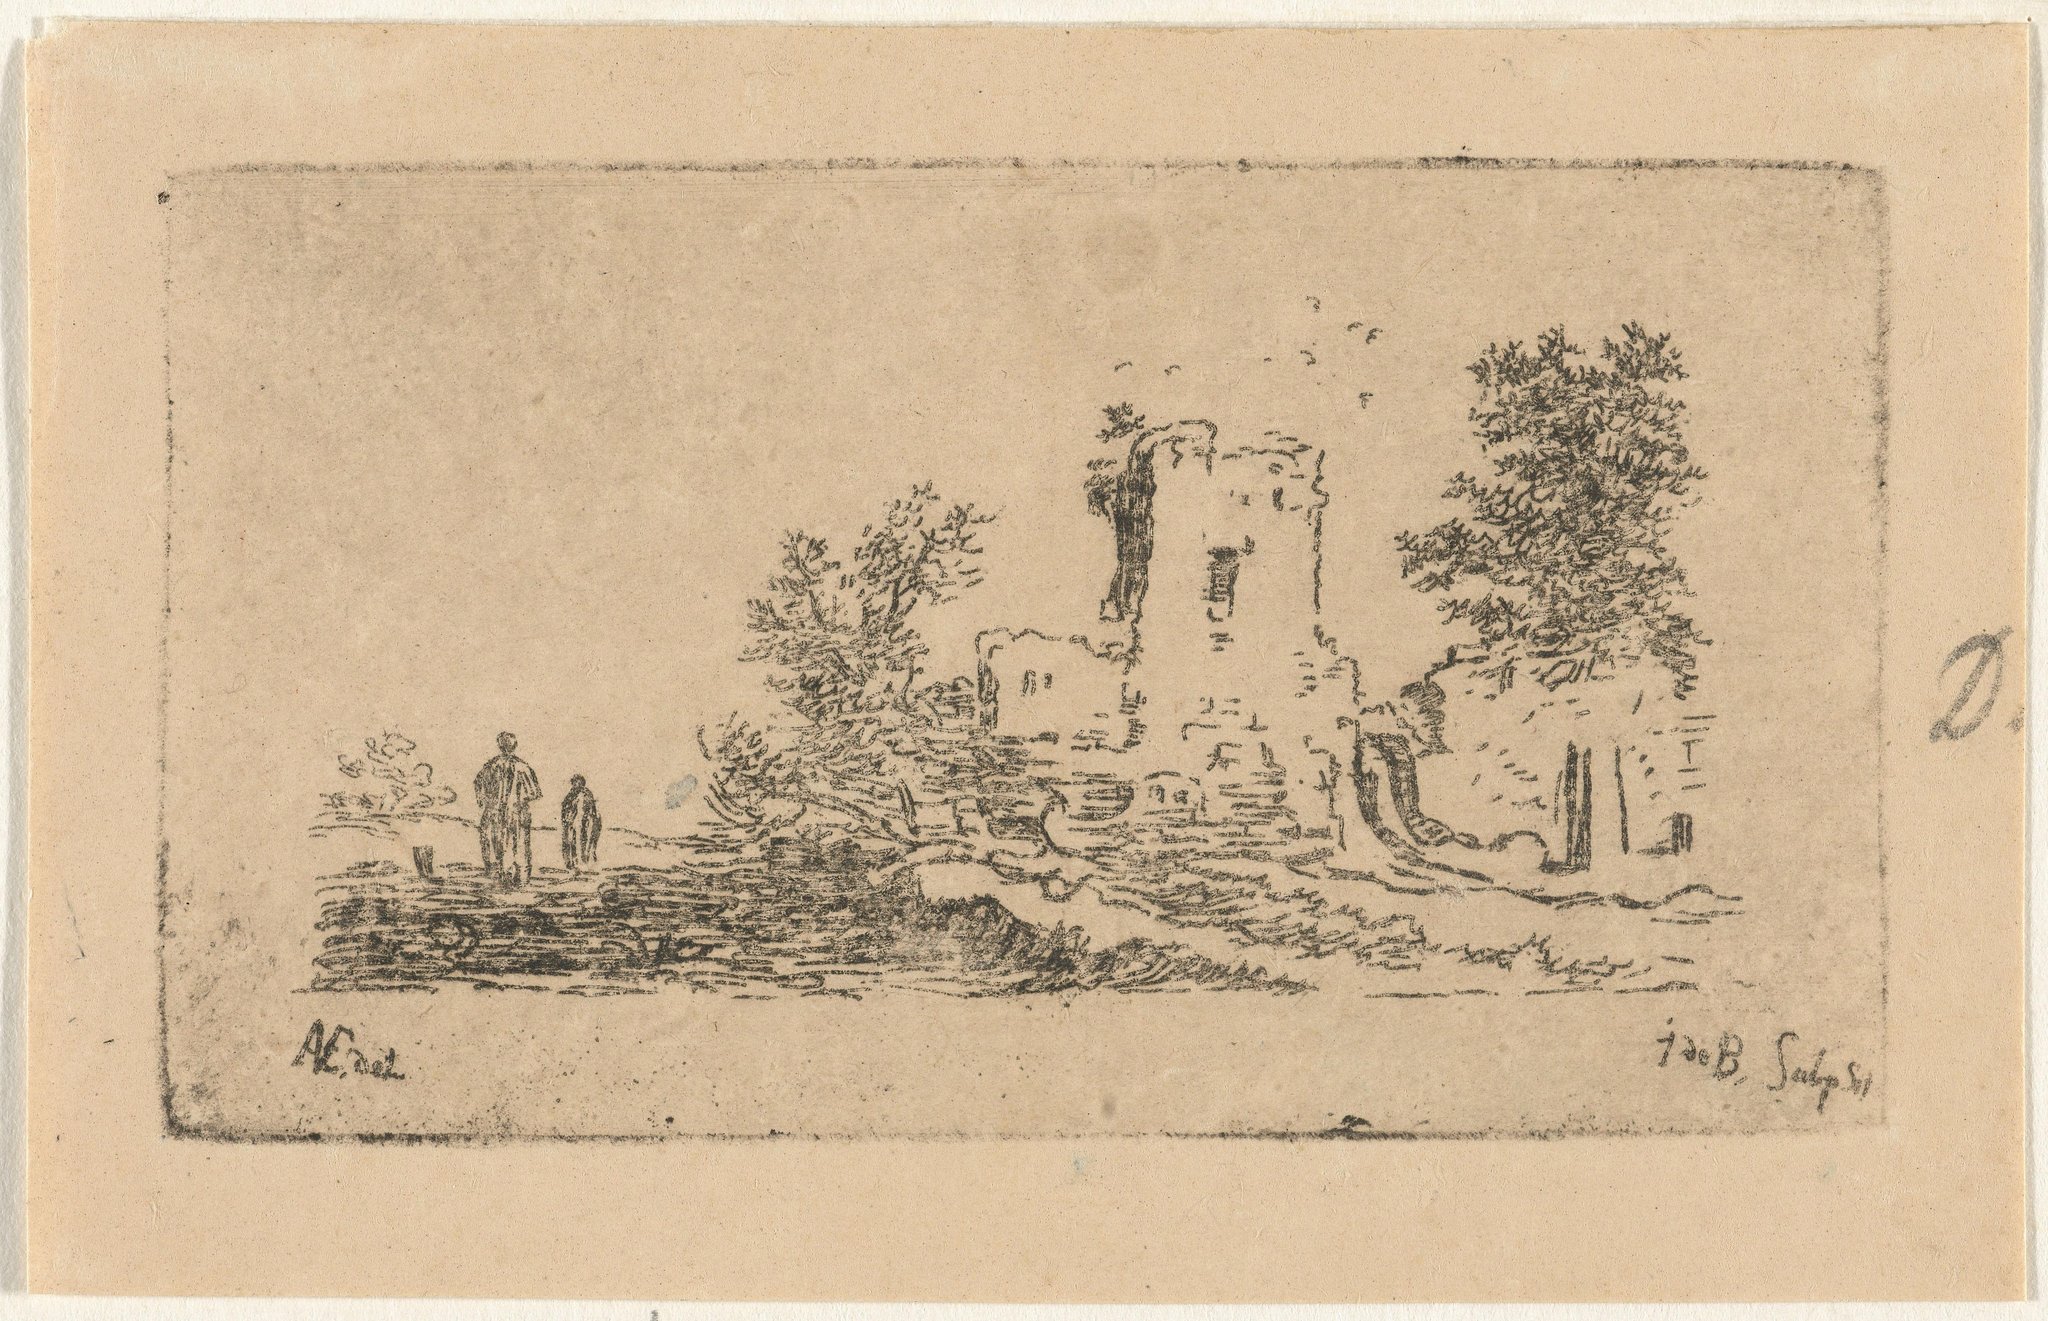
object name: print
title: Ruïne van een gebouw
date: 1796-1856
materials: paper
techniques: etching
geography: vaassen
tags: ruin of a building ~ architecture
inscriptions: collector's mark: Lugt 2228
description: De ruïne van een gebouw met een toren rechts. Twee figuren links.